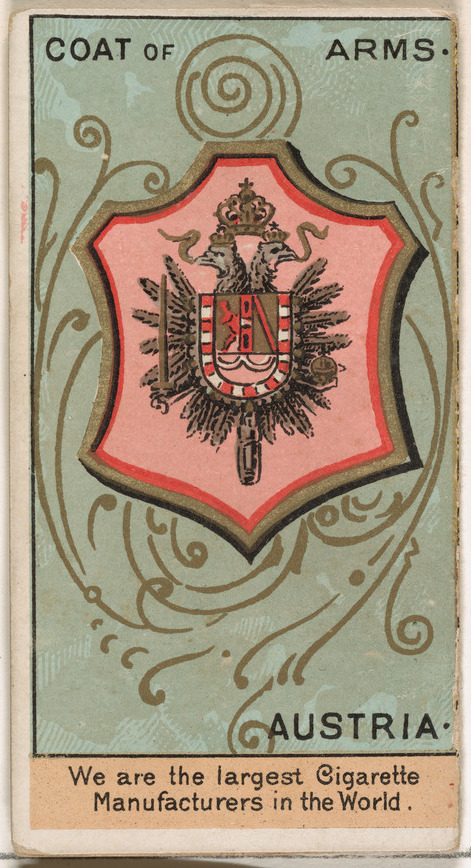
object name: print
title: Franz Joseph I, Emperor of Austria, from the Rulers, Flags, and Coats of Arms series (N126-2) issued by W. Duke, Sons & Co.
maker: w. duke, sons & co.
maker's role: publisher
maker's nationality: american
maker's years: 1870-1920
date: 1888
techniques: color lithograph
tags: men,portraits,coat of arms,flags